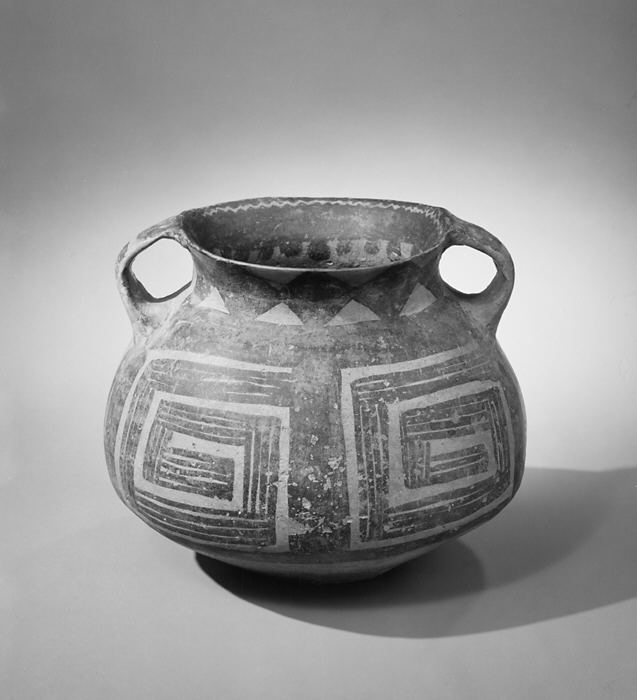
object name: jar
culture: chinese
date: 2300-2000 BCE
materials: earthenware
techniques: painting